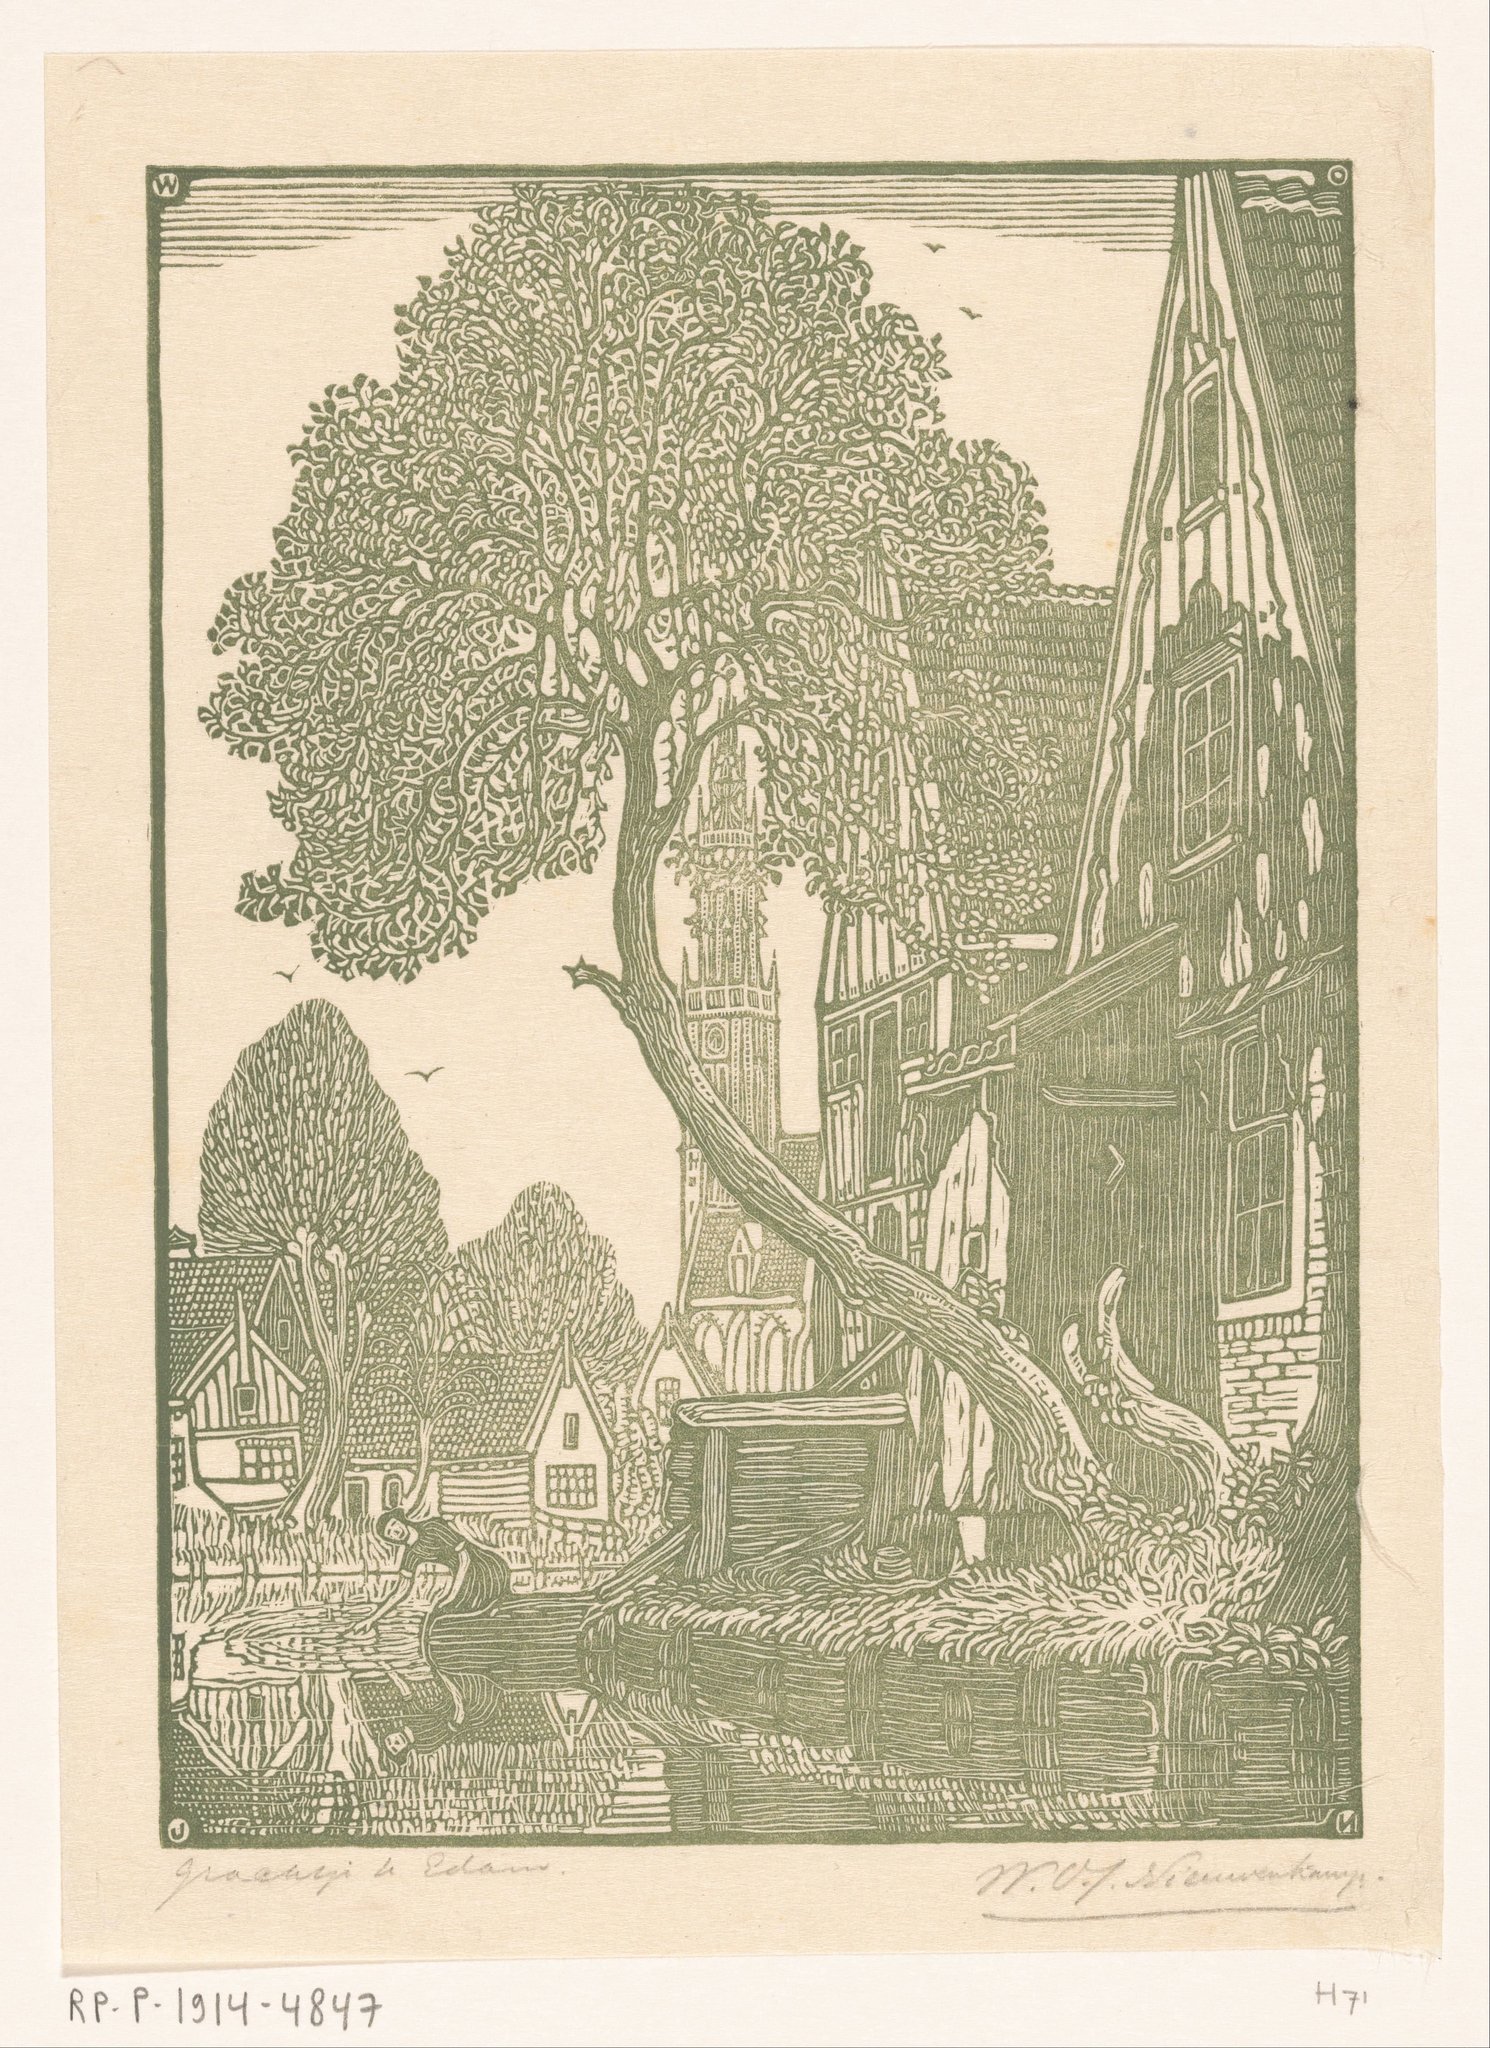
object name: print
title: Grachtje te Edam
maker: wijnand otto jan nieuwenkamp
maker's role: draughtsman, print maker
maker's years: 1874-1950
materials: paper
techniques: woodcut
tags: trees, canals, waters (in city)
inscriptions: collector's mark: Lugt 2233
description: Op de voorgrond een vlierboom naast twee pakhuizen. Op de achtergrond enkele huizen en de toren van de Onze Lieve Vrouwekerk, ook bekend als de Speeltoren.